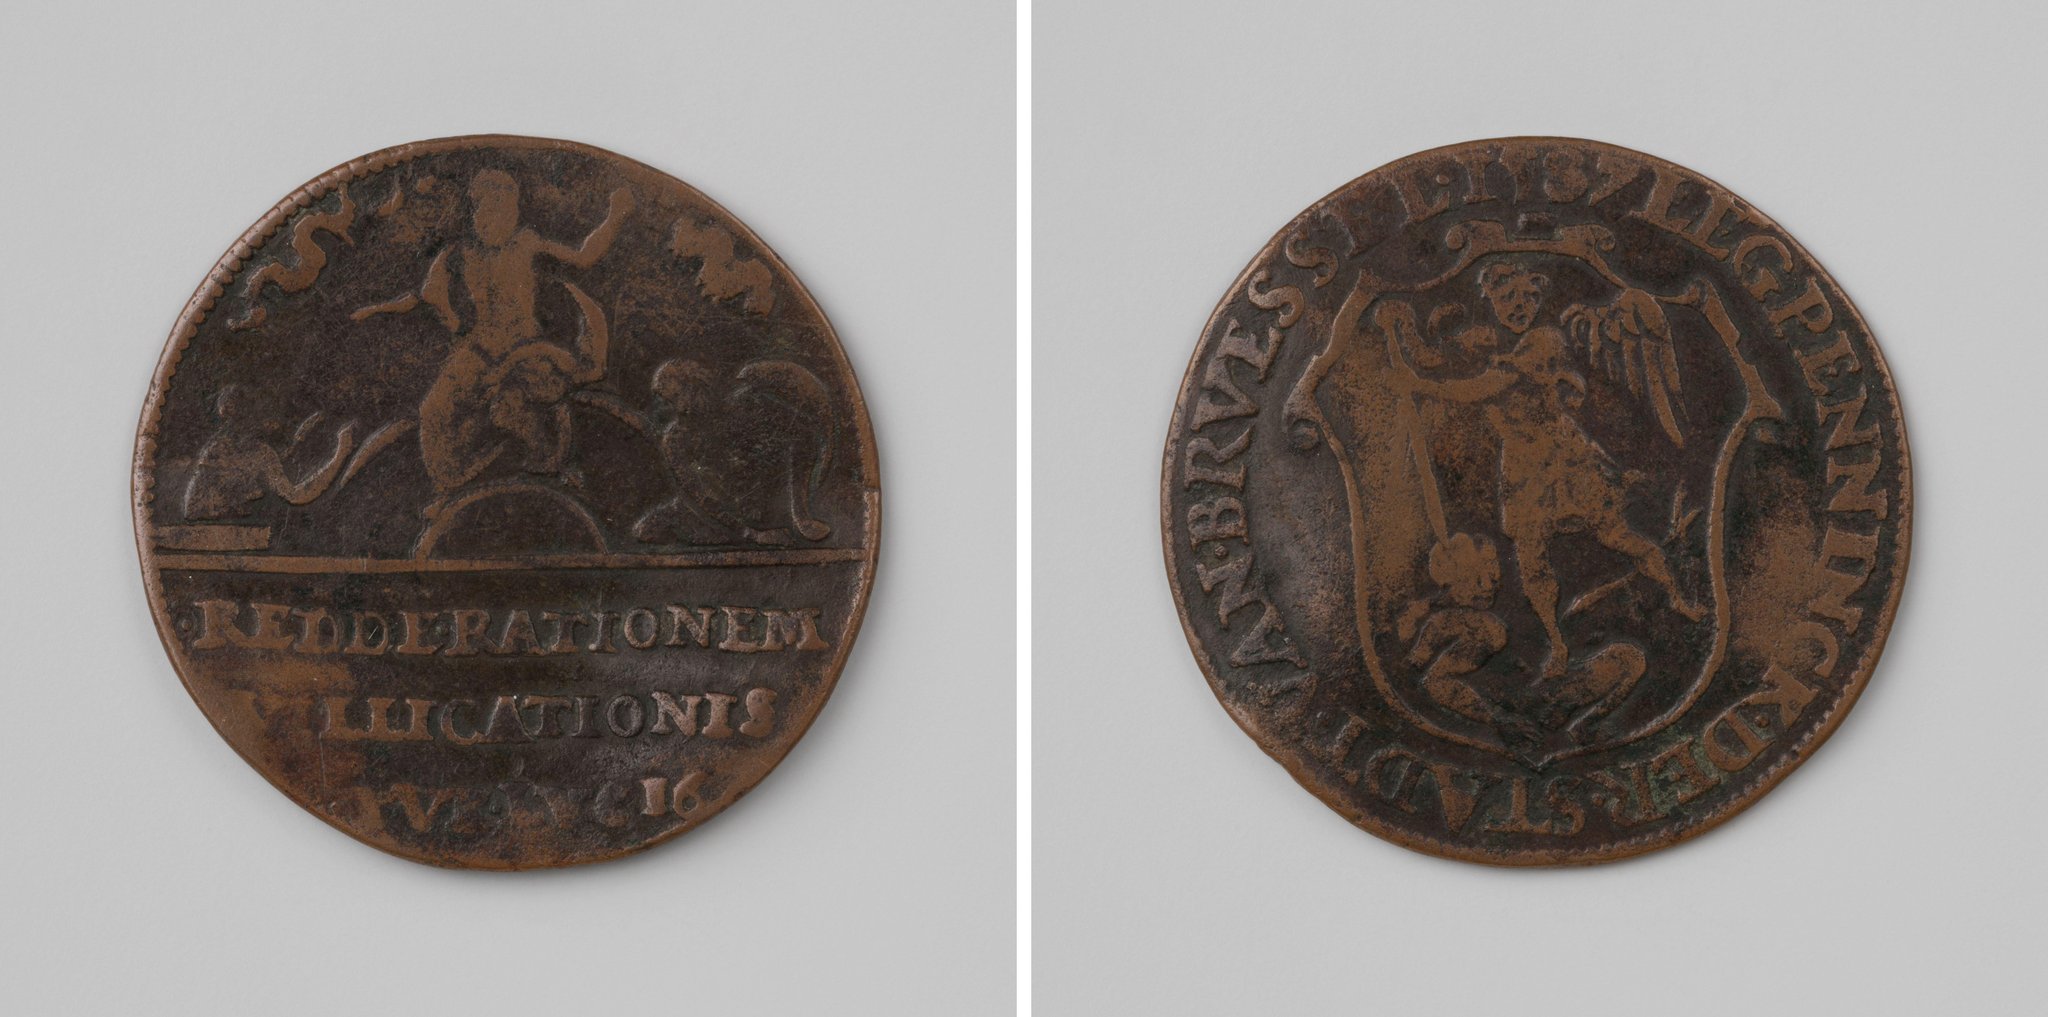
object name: jeton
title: Stad Brussel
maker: Anonymous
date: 1587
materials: copper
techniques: striking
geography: belgium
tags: brussels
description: Koperen penning. Voorzijde: Christus met uitgestrekte handen, staande op wereldbol, geflankeerd door twee mensen; afsnede: opschrift. Keerzijde: wapenschild binnen omschrift